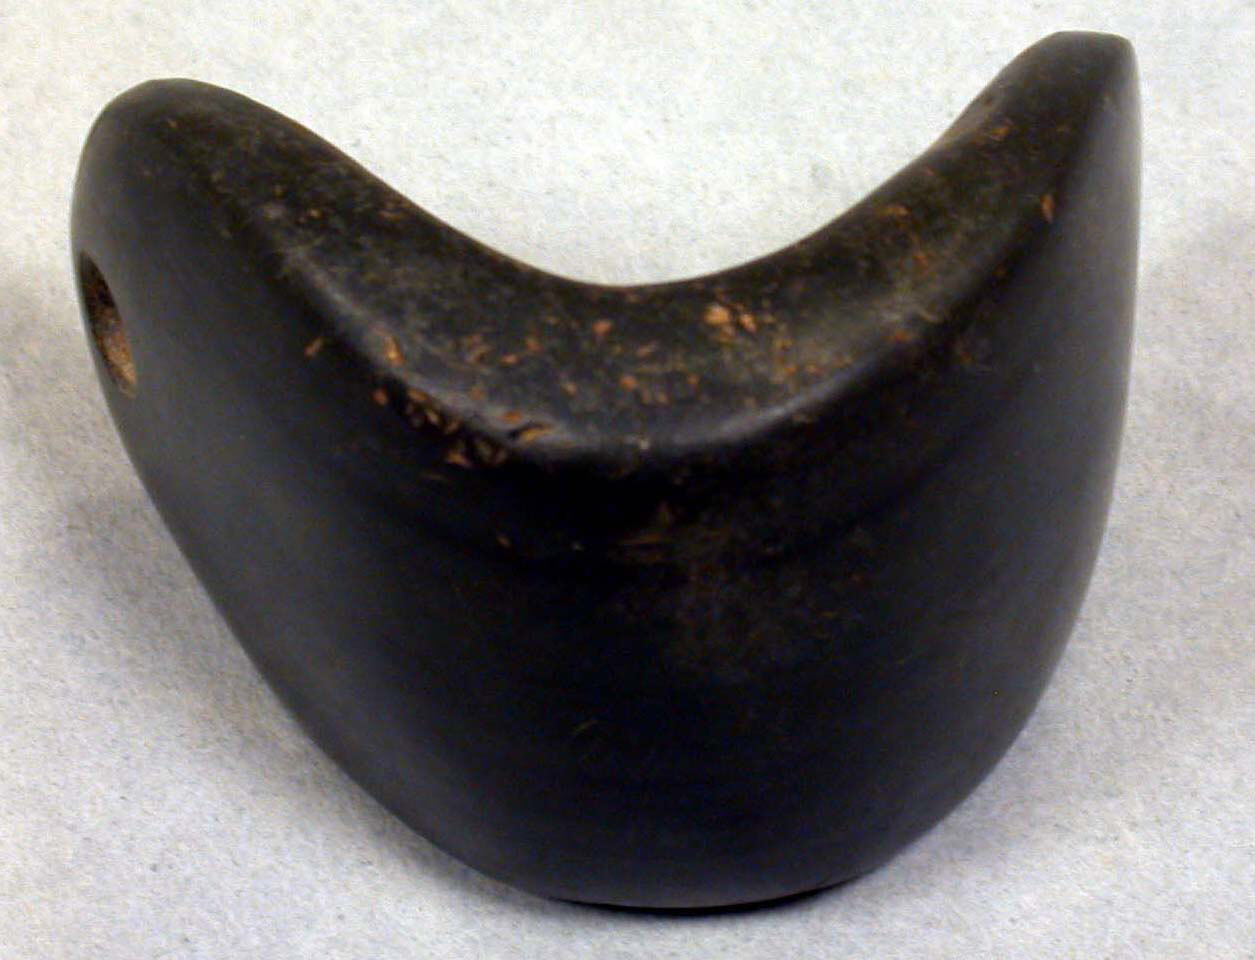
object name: finger grip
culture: colima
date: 1501-1600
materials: stone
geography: mexico